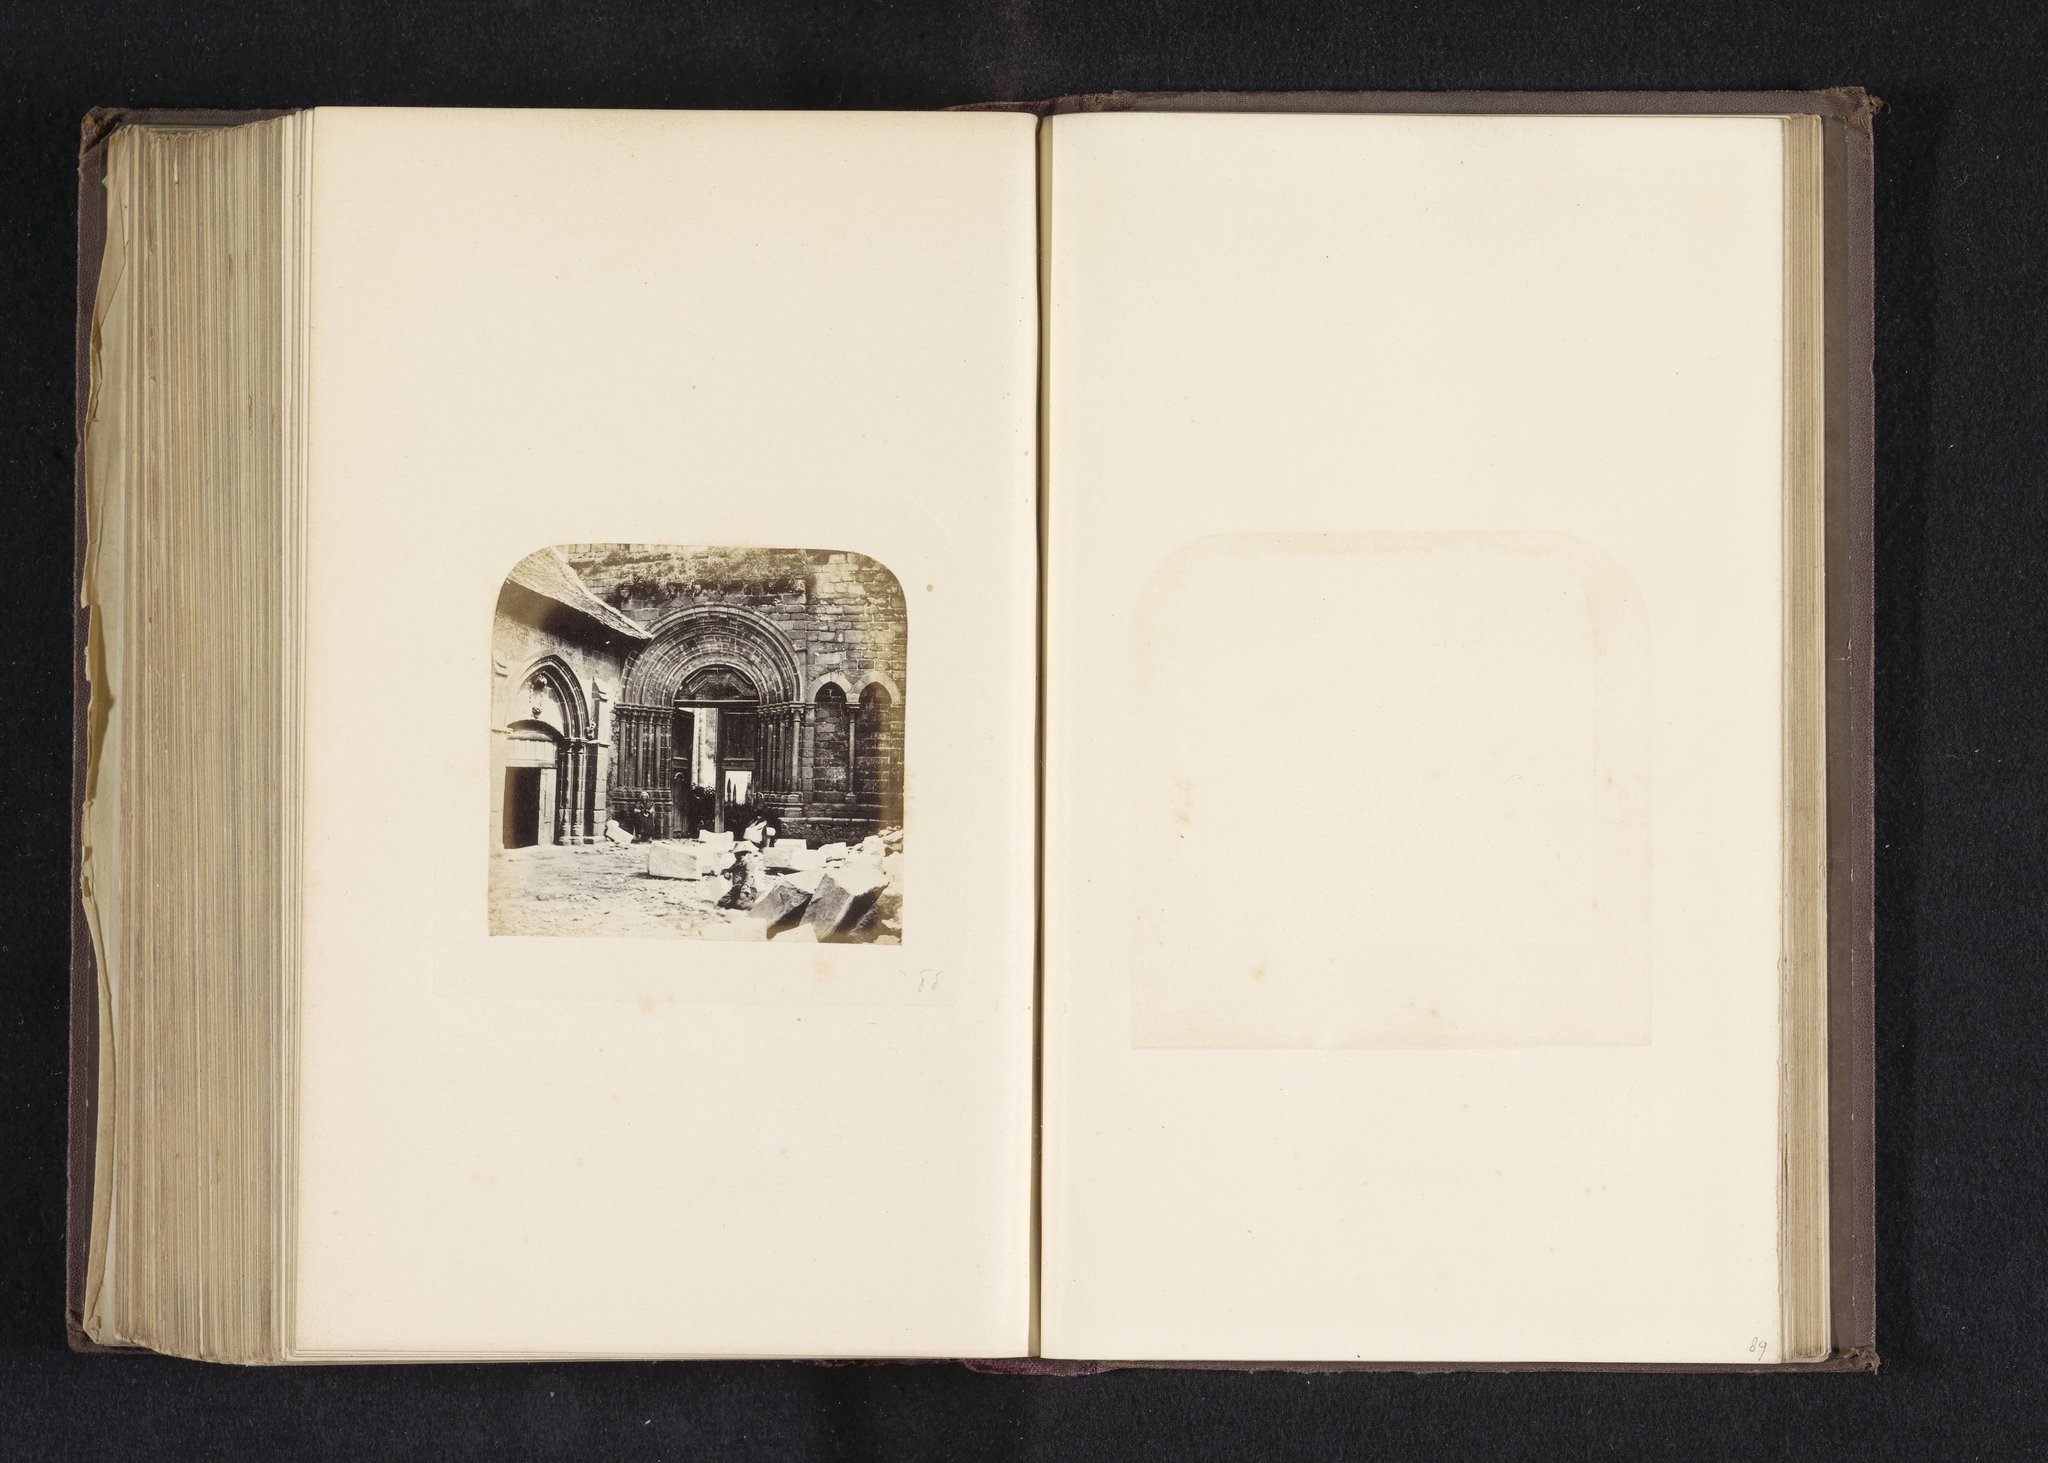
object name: photograph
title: Gezicht op de westelijke deur van de Abdij van Léhon bij Dinan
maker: taylor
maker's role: fotograaf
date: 1850-1859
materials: photographic support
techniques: albumen print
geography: dinan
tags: parts of church exterior and annexes: portal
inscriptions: number: ‘88’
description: Foto op derde ongenummerde pagina na pagina 294.